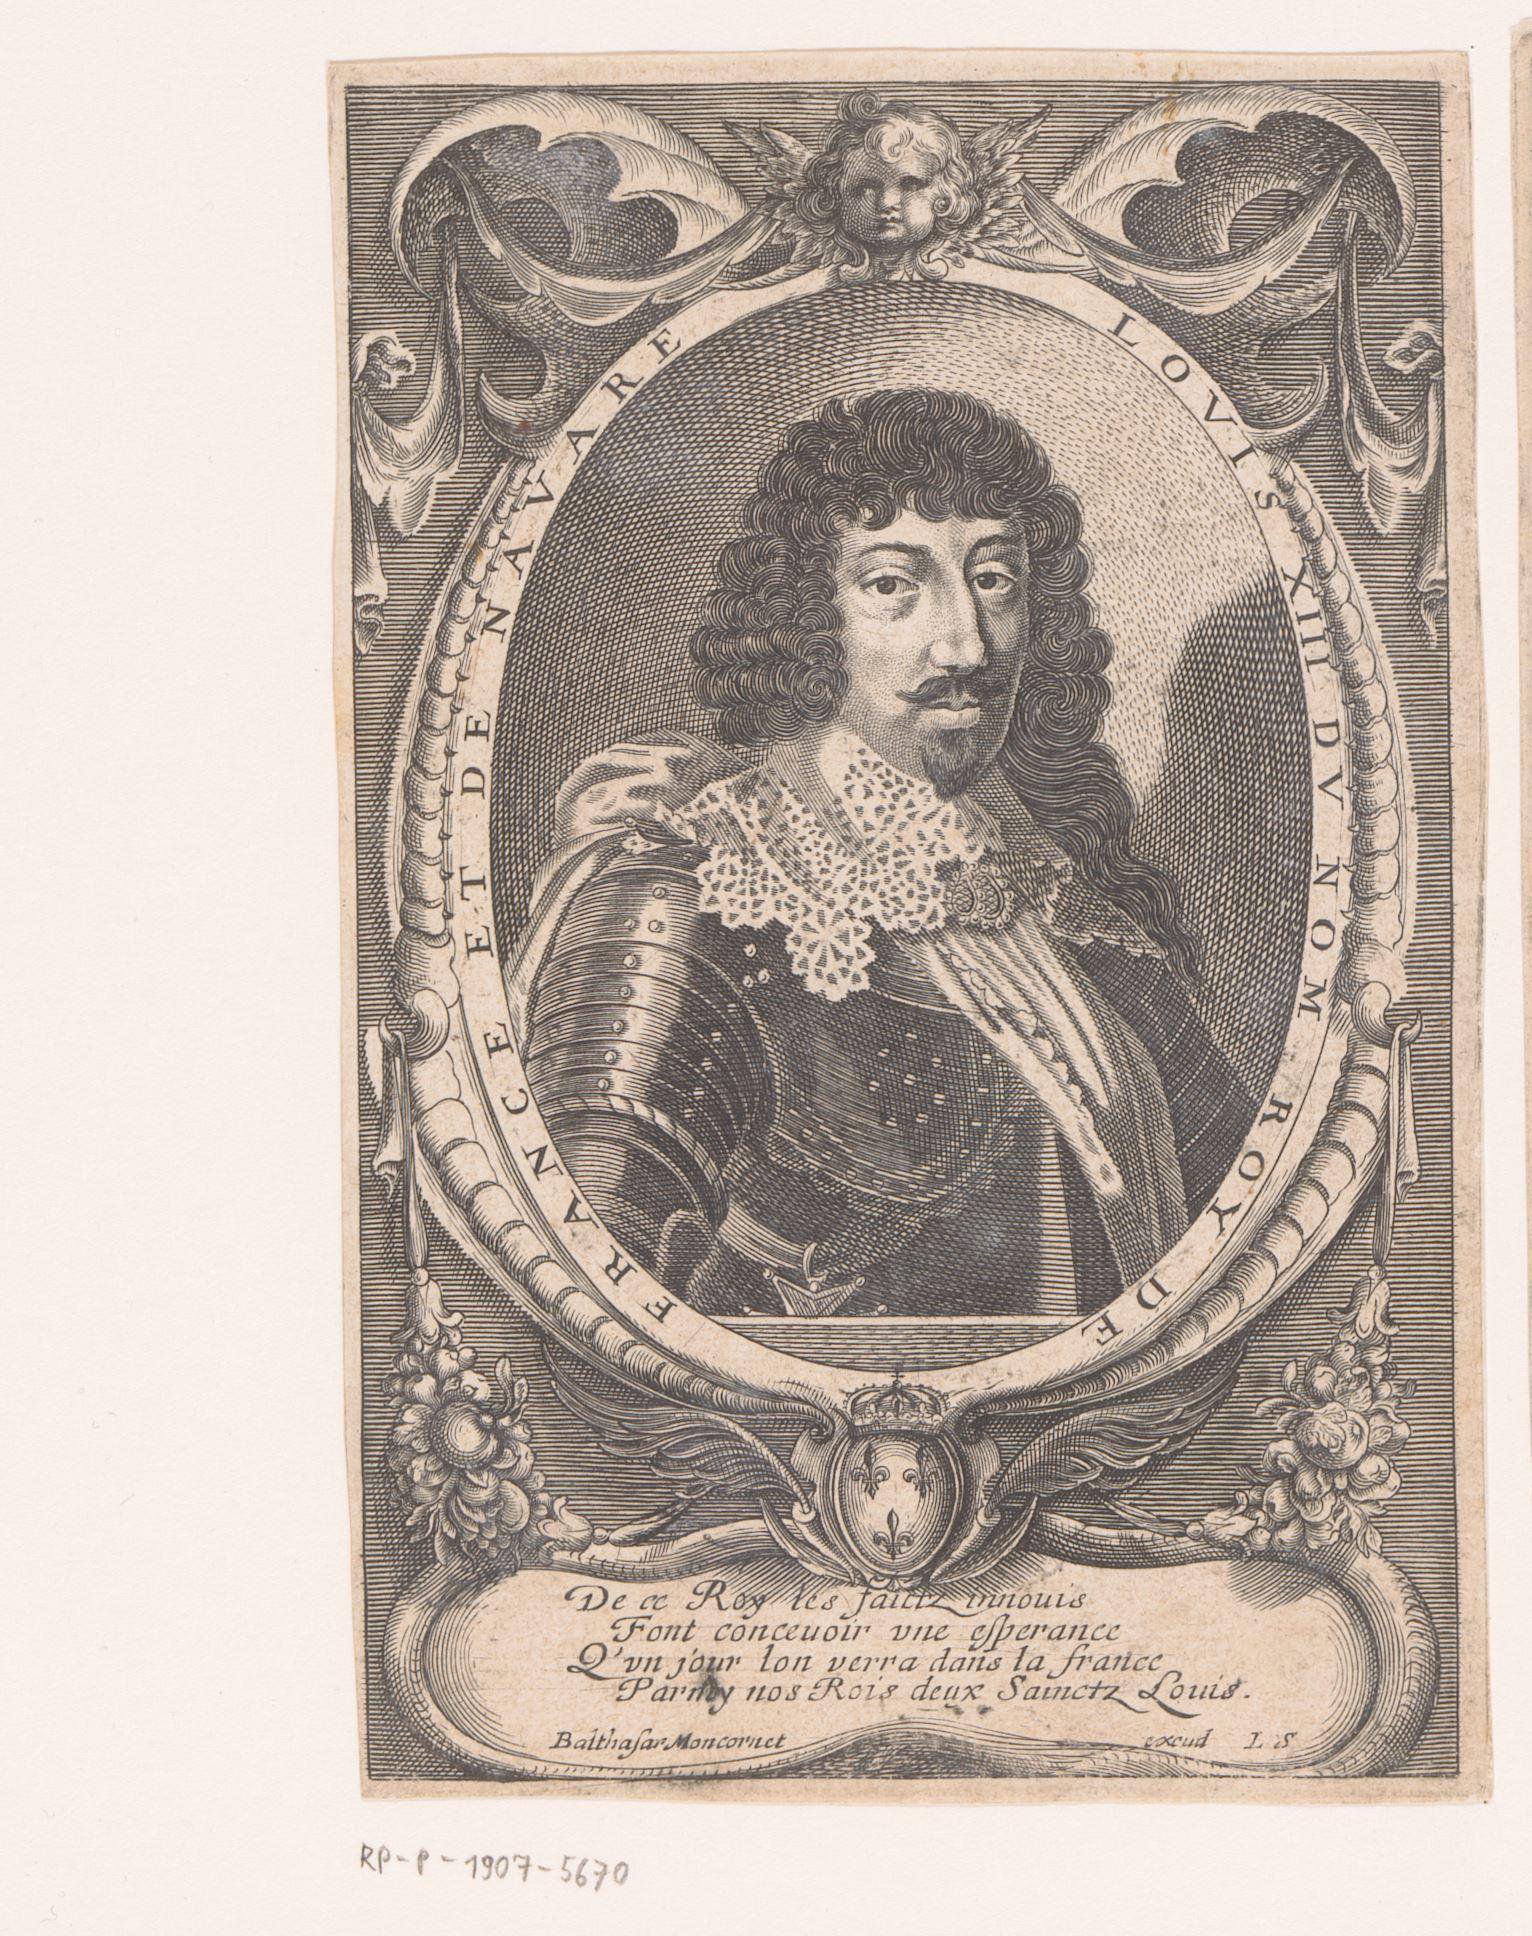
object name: print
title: Portret van Lodewijk XIII van Frankrijk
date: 1636-1668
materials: paper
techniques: engraving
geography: paris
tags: lodewijk xiii (koning van frankrijk), historical persons, king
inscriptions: collector's mark: Lugt 2228